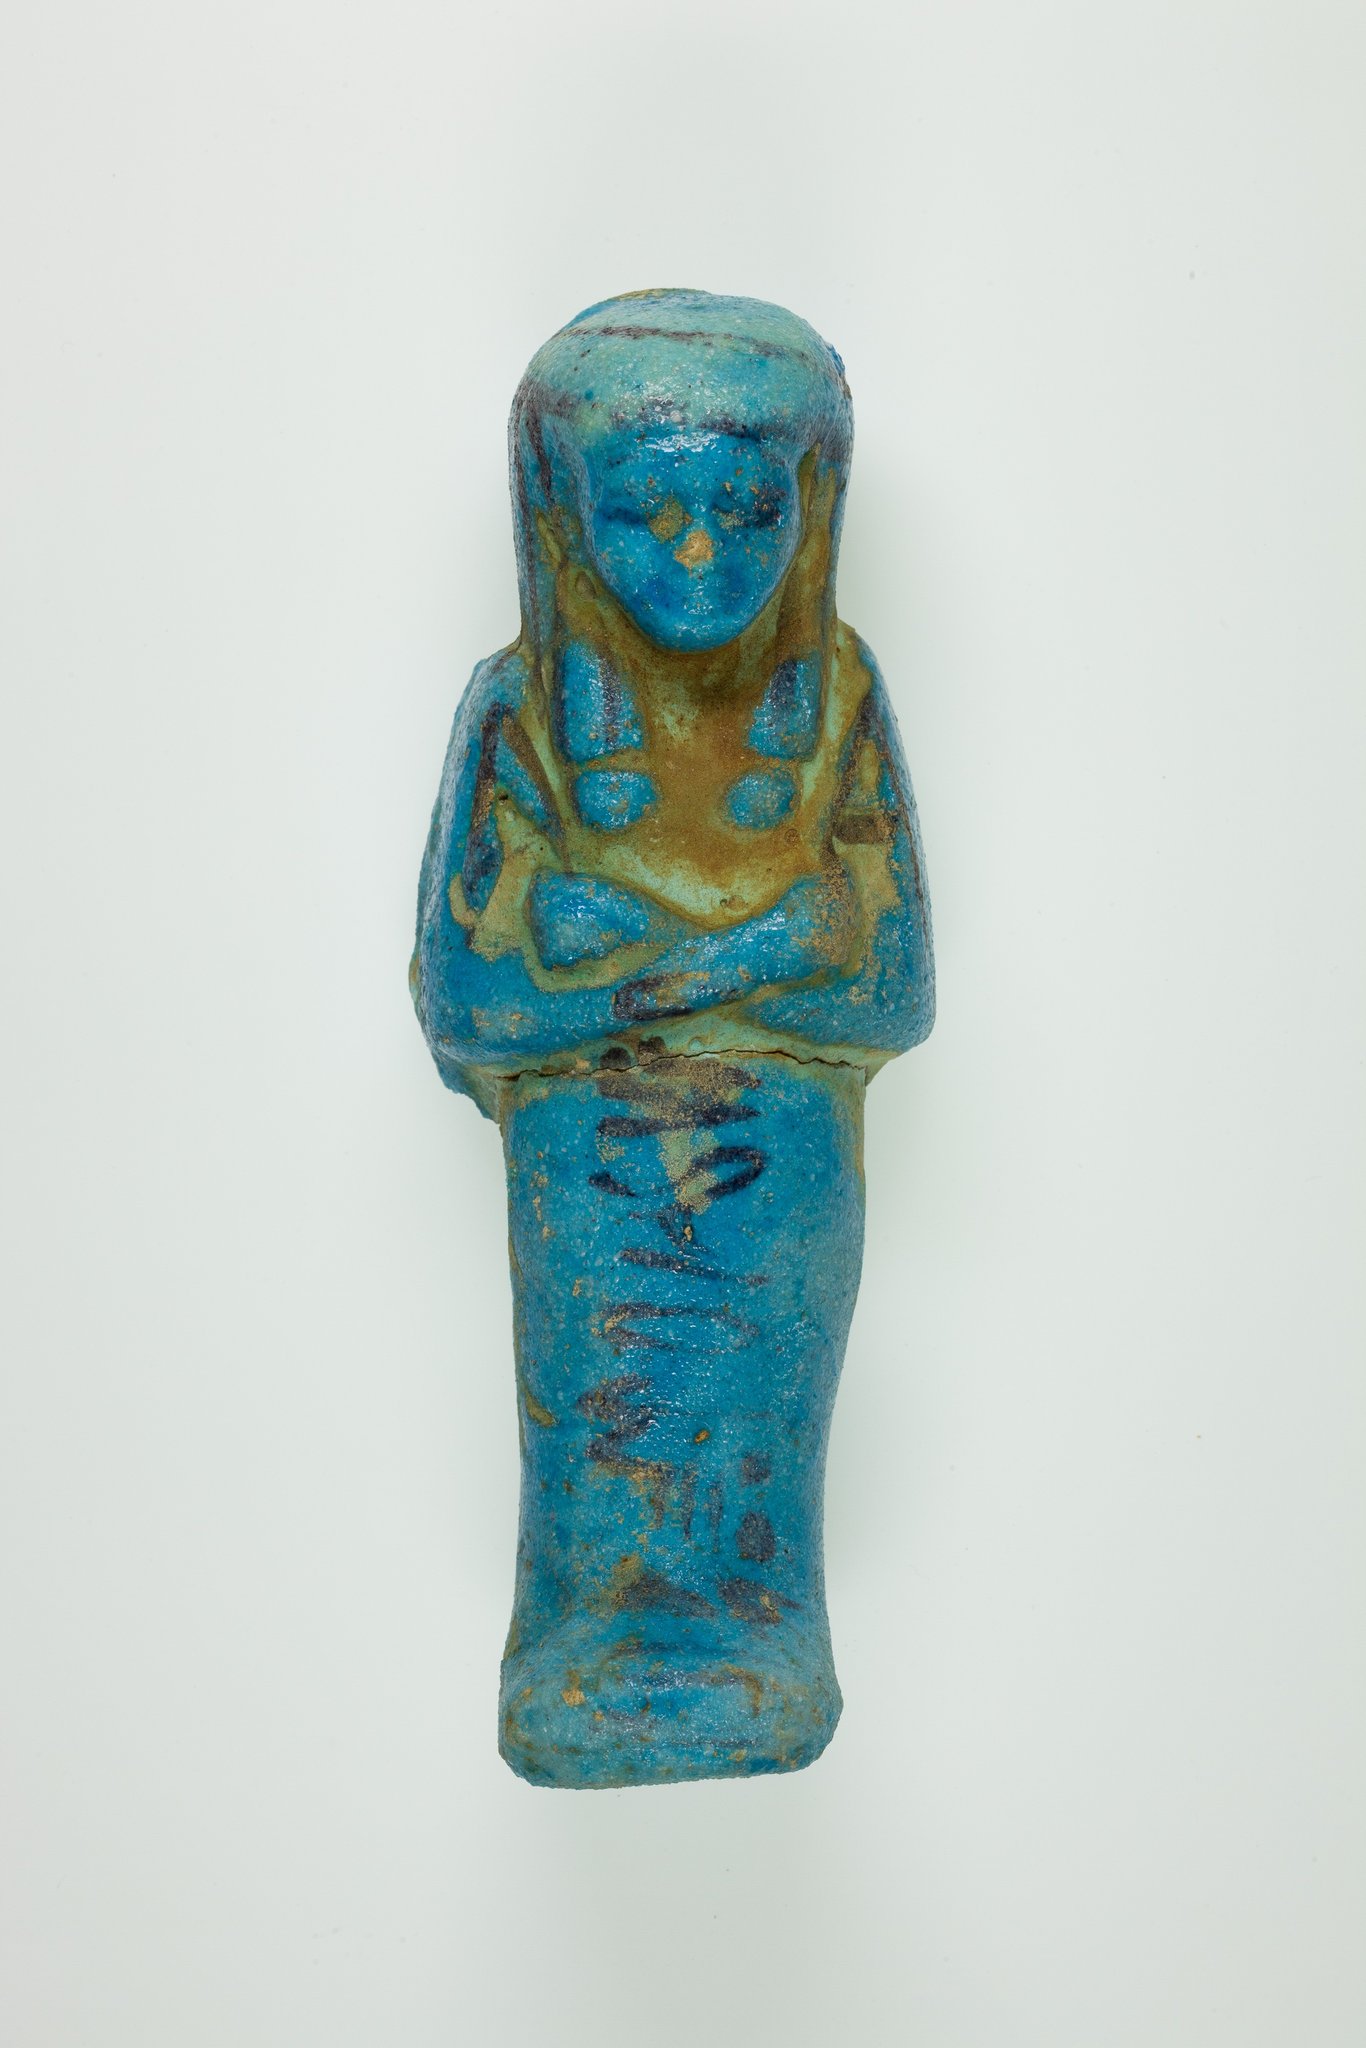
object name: worker shabti, henettawy c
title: Worker Shabti of Henettawy (C), Daughter of Isetemkheb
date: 990-970 BCE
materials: faience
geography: egypt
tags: hieroglyphs